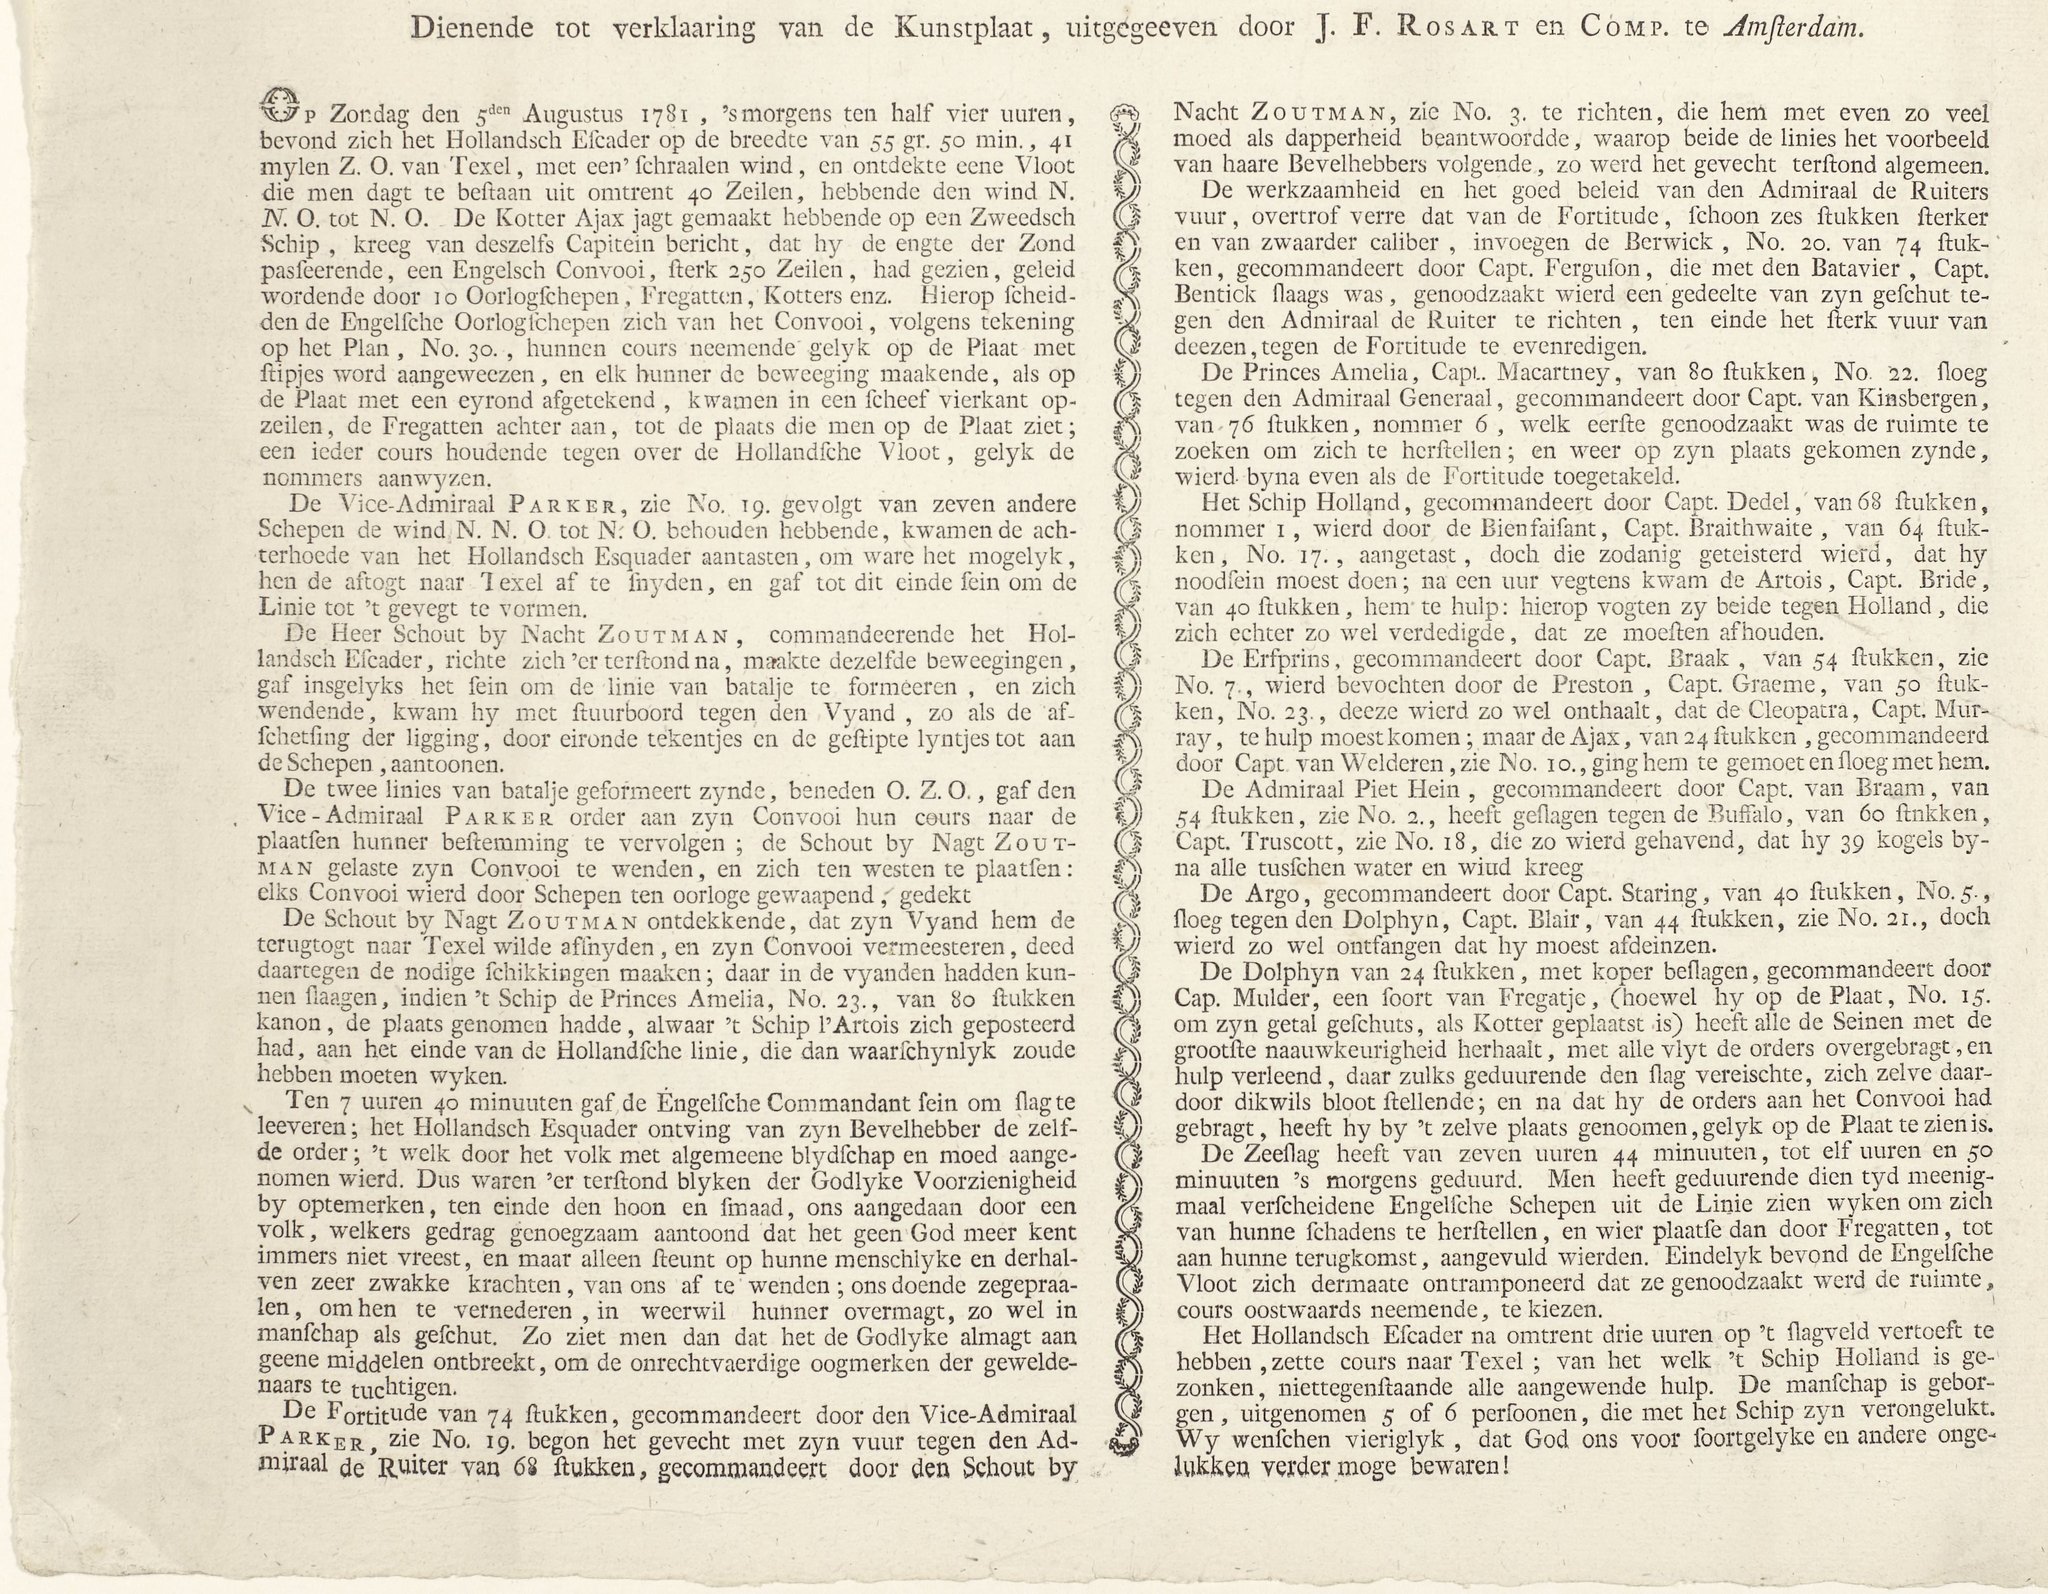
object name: text sheet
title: Tekstblad met de prent met de kaart met slagordes van de Nederlandse en Engelse schepen bij de zeeslag bij Doggersbank, 1781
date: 1781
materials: paper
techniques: letterpress printing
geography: amsterdam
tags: the hague, johan arnold zoutman, hyde parker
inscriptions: collector's mark: Lugt 2228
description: Tekstblad behorend bij de prent met de kaart met de slagordes van de Nederlandse en Engelse schepen tijdens de zeeslag bij Doggersbank op 5 augustus 1781. Beschrijving van de gebeurtenissen in het Nederlands in twee kolommen.